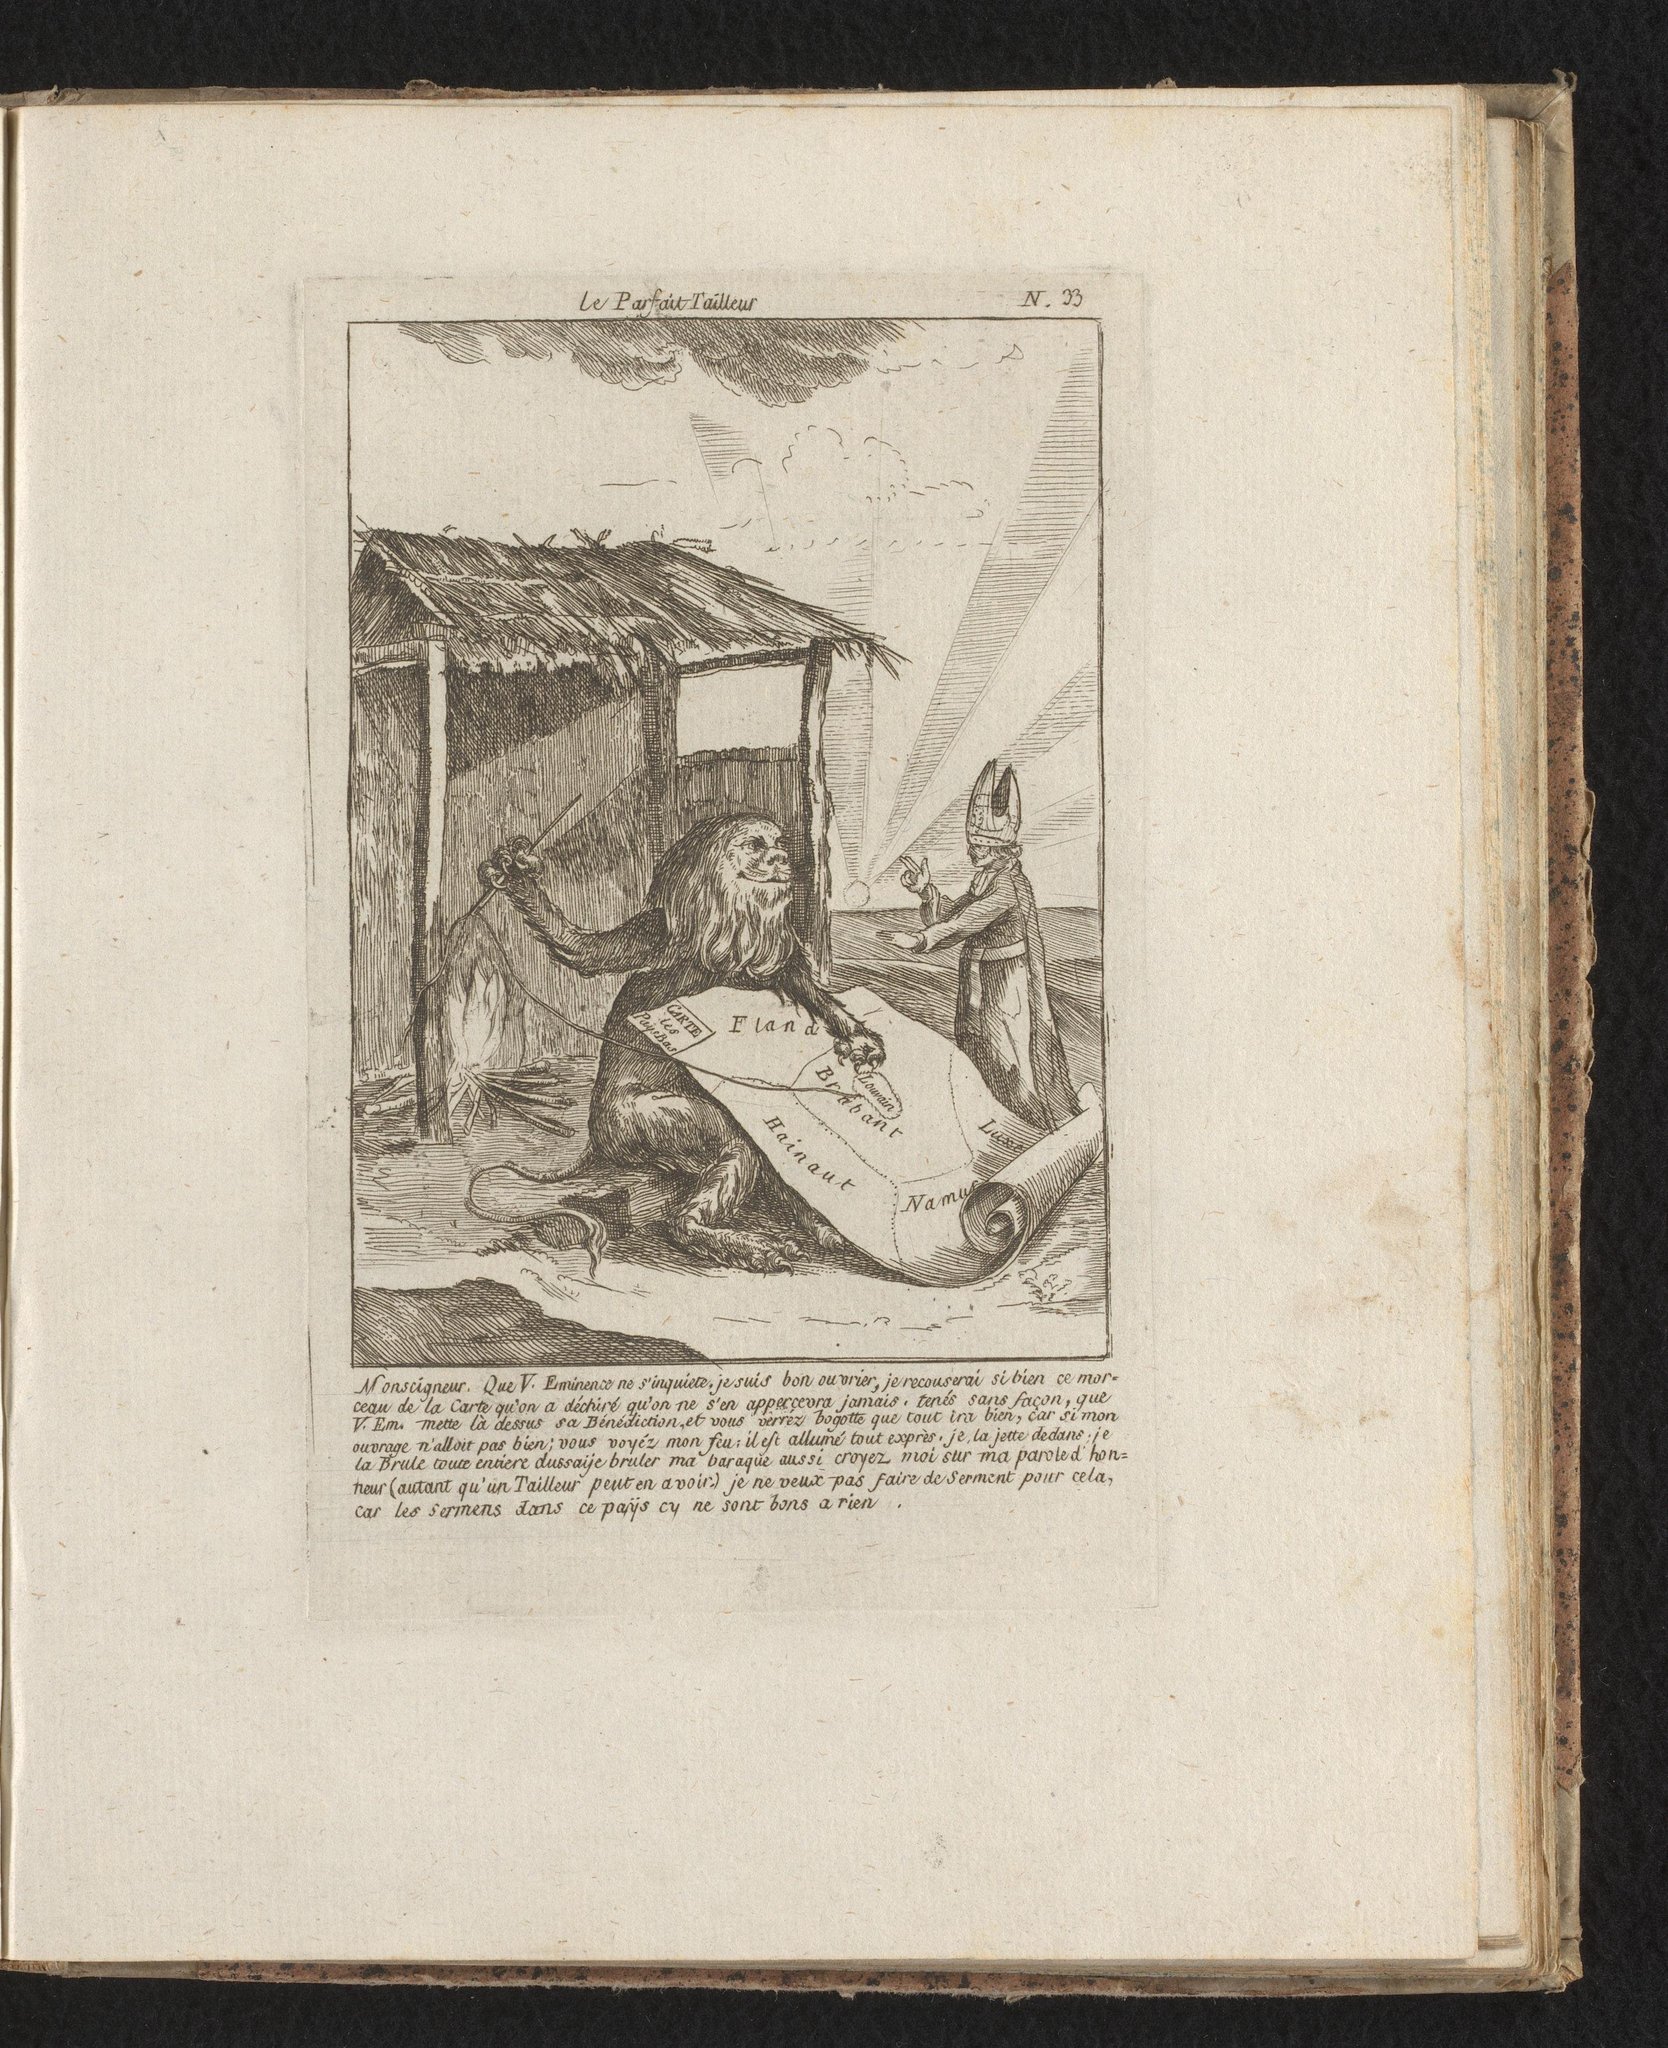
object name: print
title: Brabantse leeuw verstelt de kaart van de Oostenrijkse Nederlanden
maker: Anonymous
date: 1787-1790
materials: paper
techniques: engraving, etching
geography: southern netherlands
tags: animals acting as human beings, sewing, brabant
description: De Brabantse leeuw stikt met naald en draad Leuven op de kaart van de Oostenrijkse Nederlanden, een bisschop zegent zijn werk. Met Frans onderschrift van zeven regels. Genummerd rechtsboven: No. 33. Onderdeel van de gebundelde verzameling prenten betrekking hebbend op de gebeurtenissen van de Brabantse Omwenteling en de periode 1787-1790.